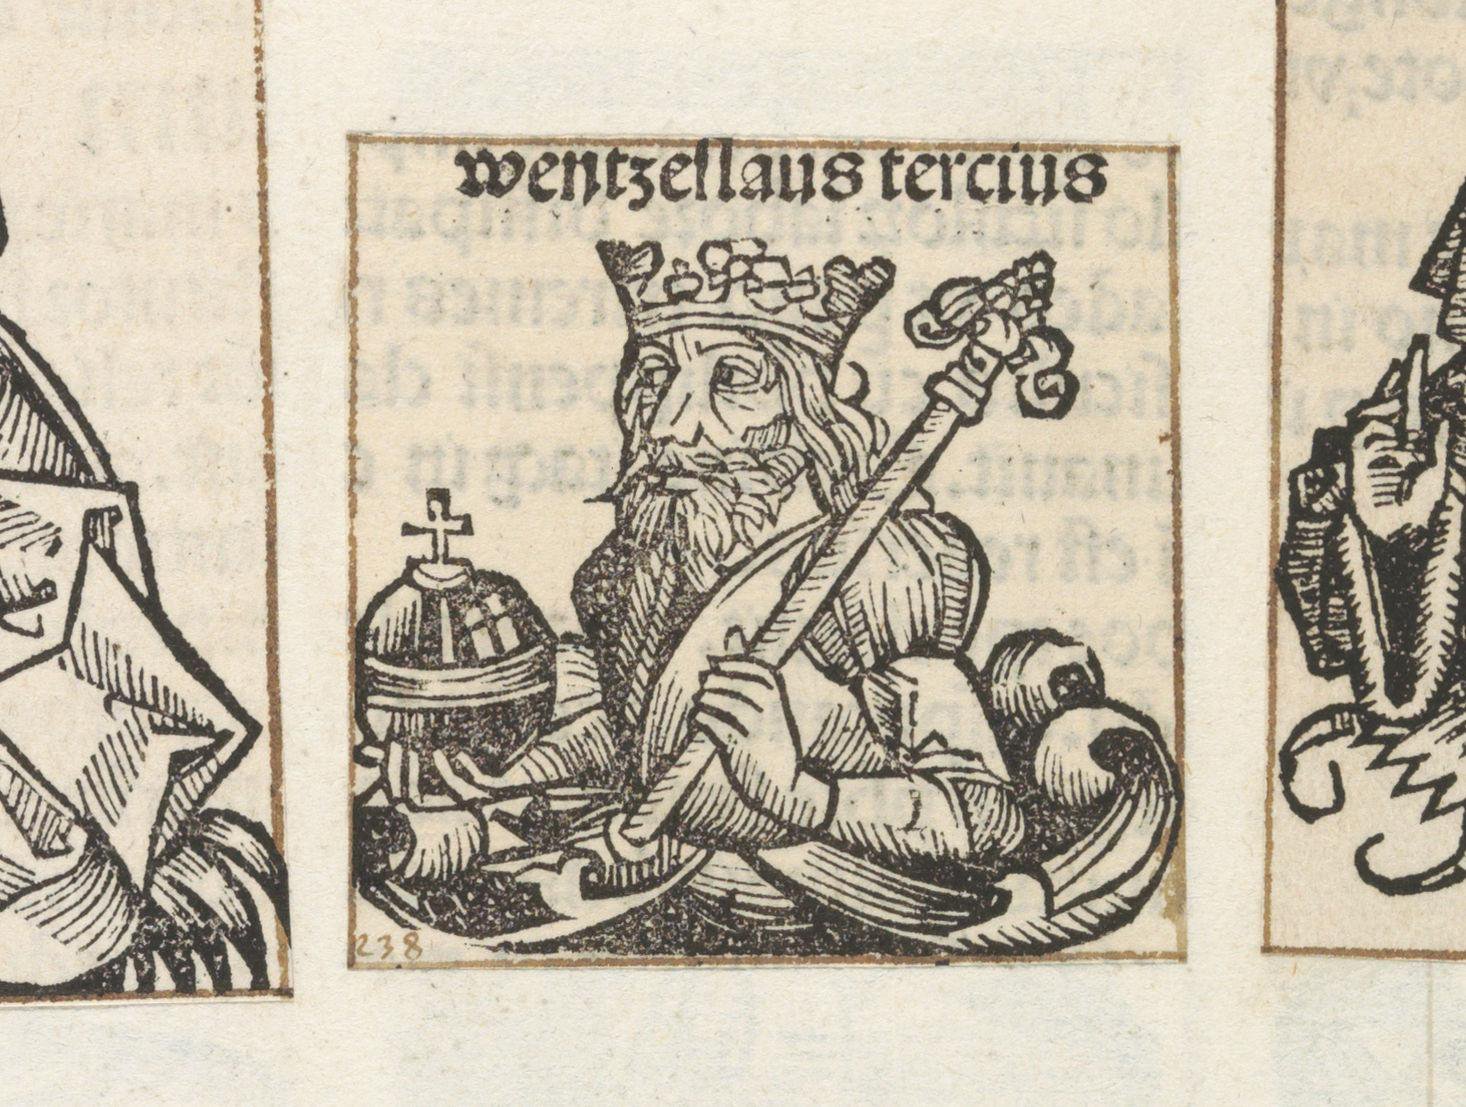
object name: album leaf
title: Wentzeslaus tercius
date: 1493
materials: paper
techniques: letterpress printing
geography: nuremberg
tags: king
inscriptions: inscription: ‘238’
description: De houtsnede wordt herhaaldelijk gebruikt als boekillustratie in de Liber Chronicarum (of Neurenbergkroniek) van Hartmann Schedel, verschenen in het Latijn en Duits in 1493. Zie de Latijnse uitgave, folio 220r.